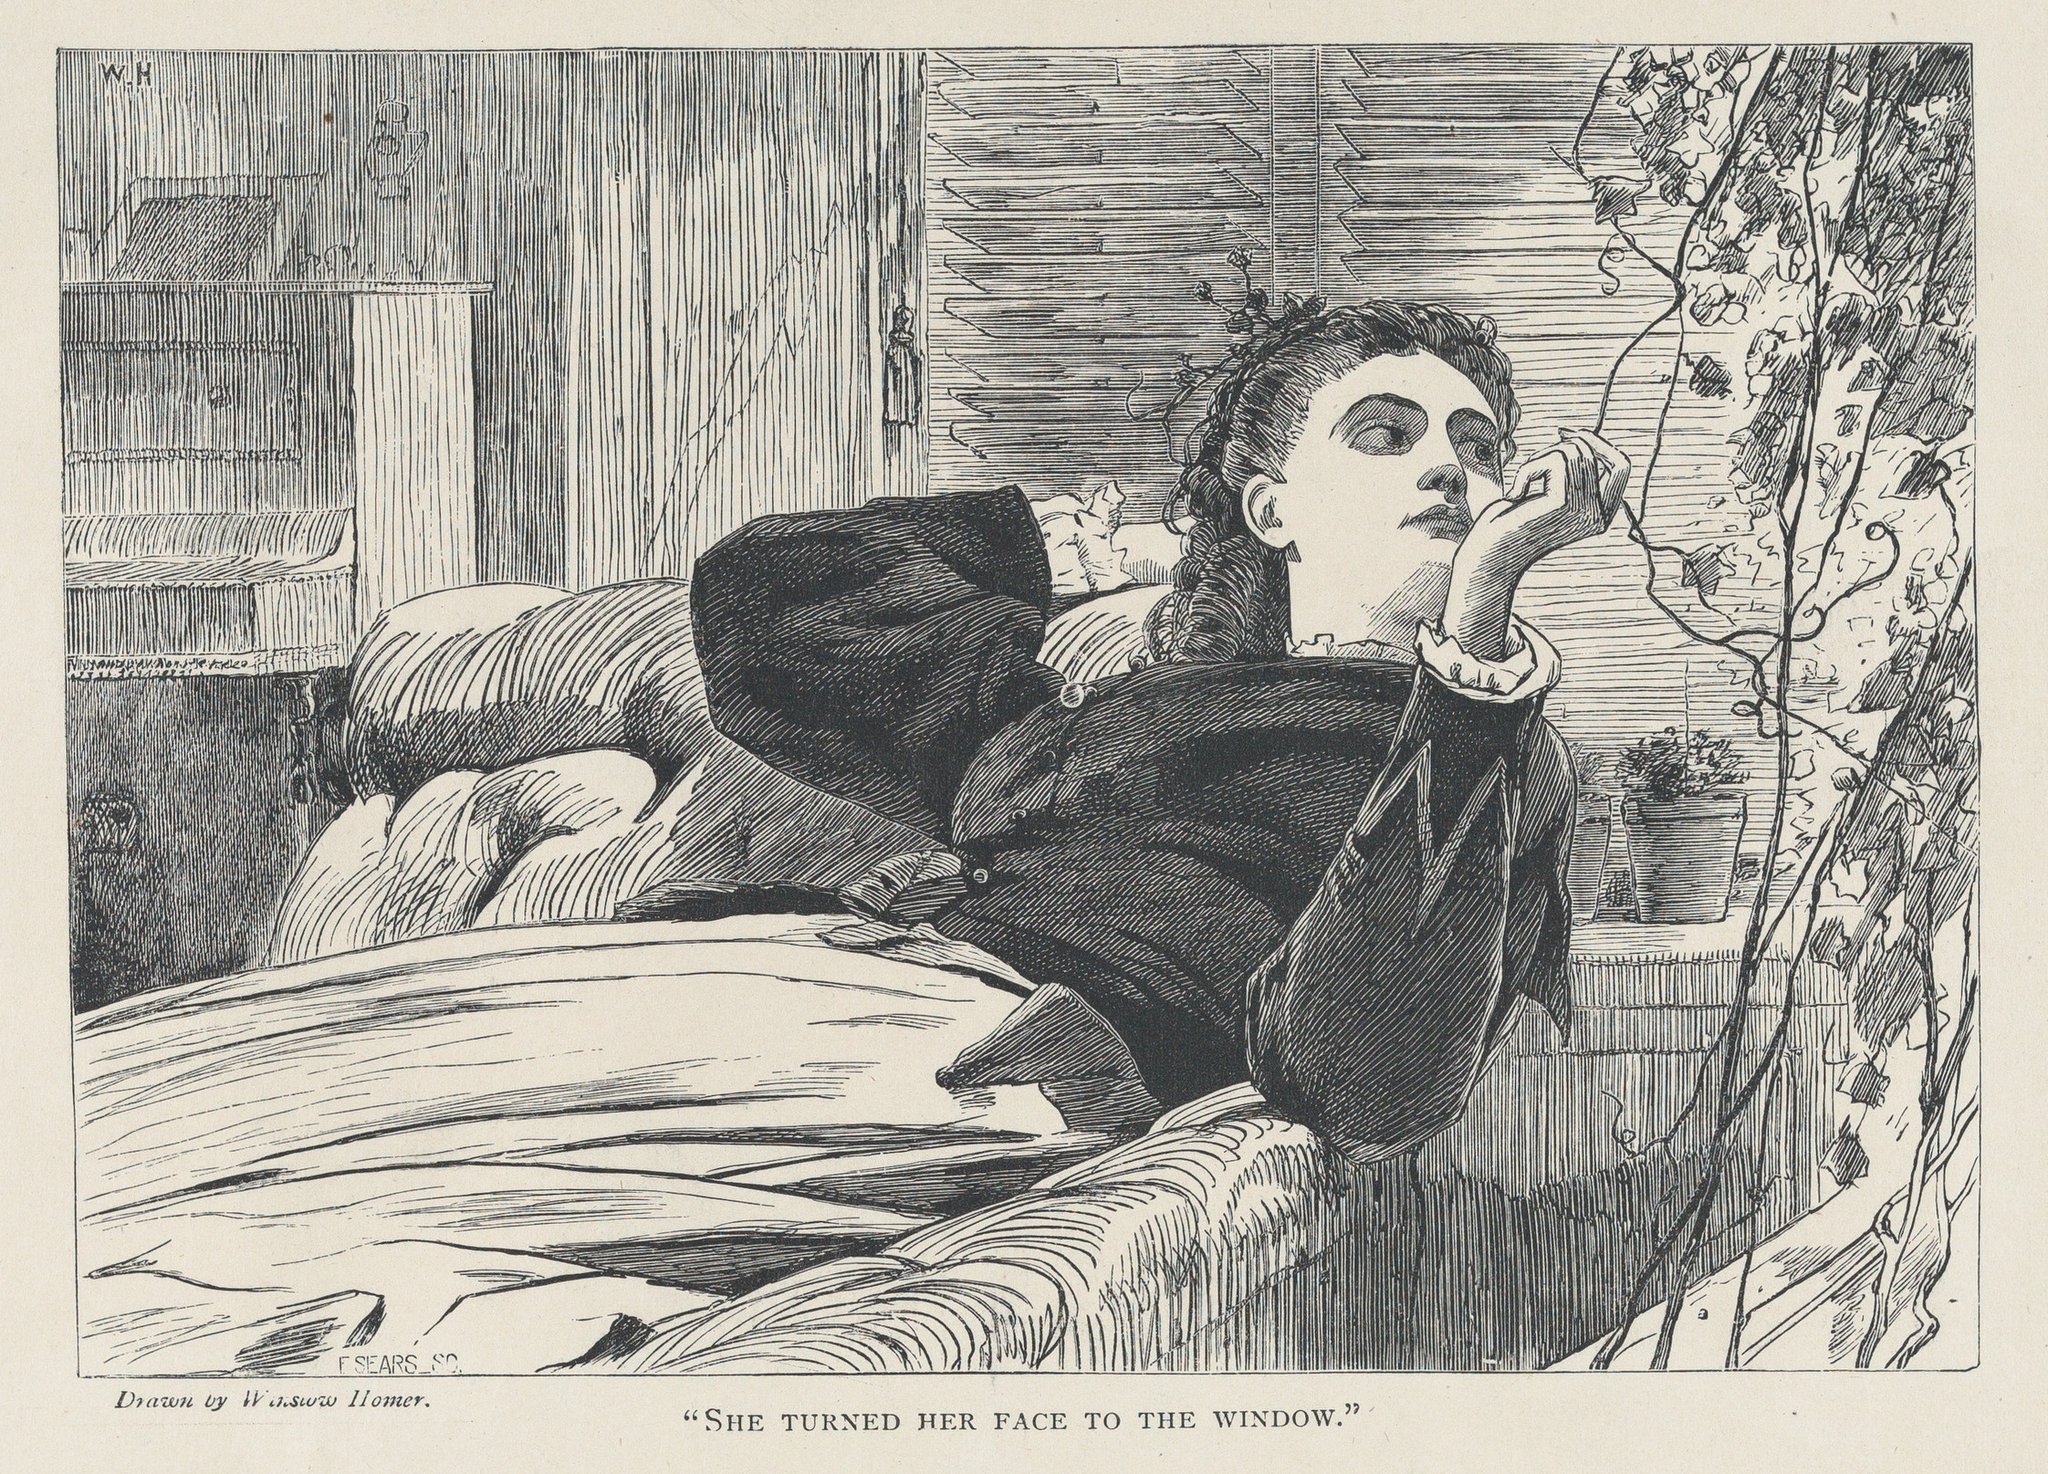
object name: print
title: "She Turned her Face to the Window" (The Galaxy, An Illustrated Magazine of Entertaining Reading, Vol. V)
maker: winslow homer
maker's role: artist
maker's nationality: american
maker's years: 1836-1910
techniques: engraving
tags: women